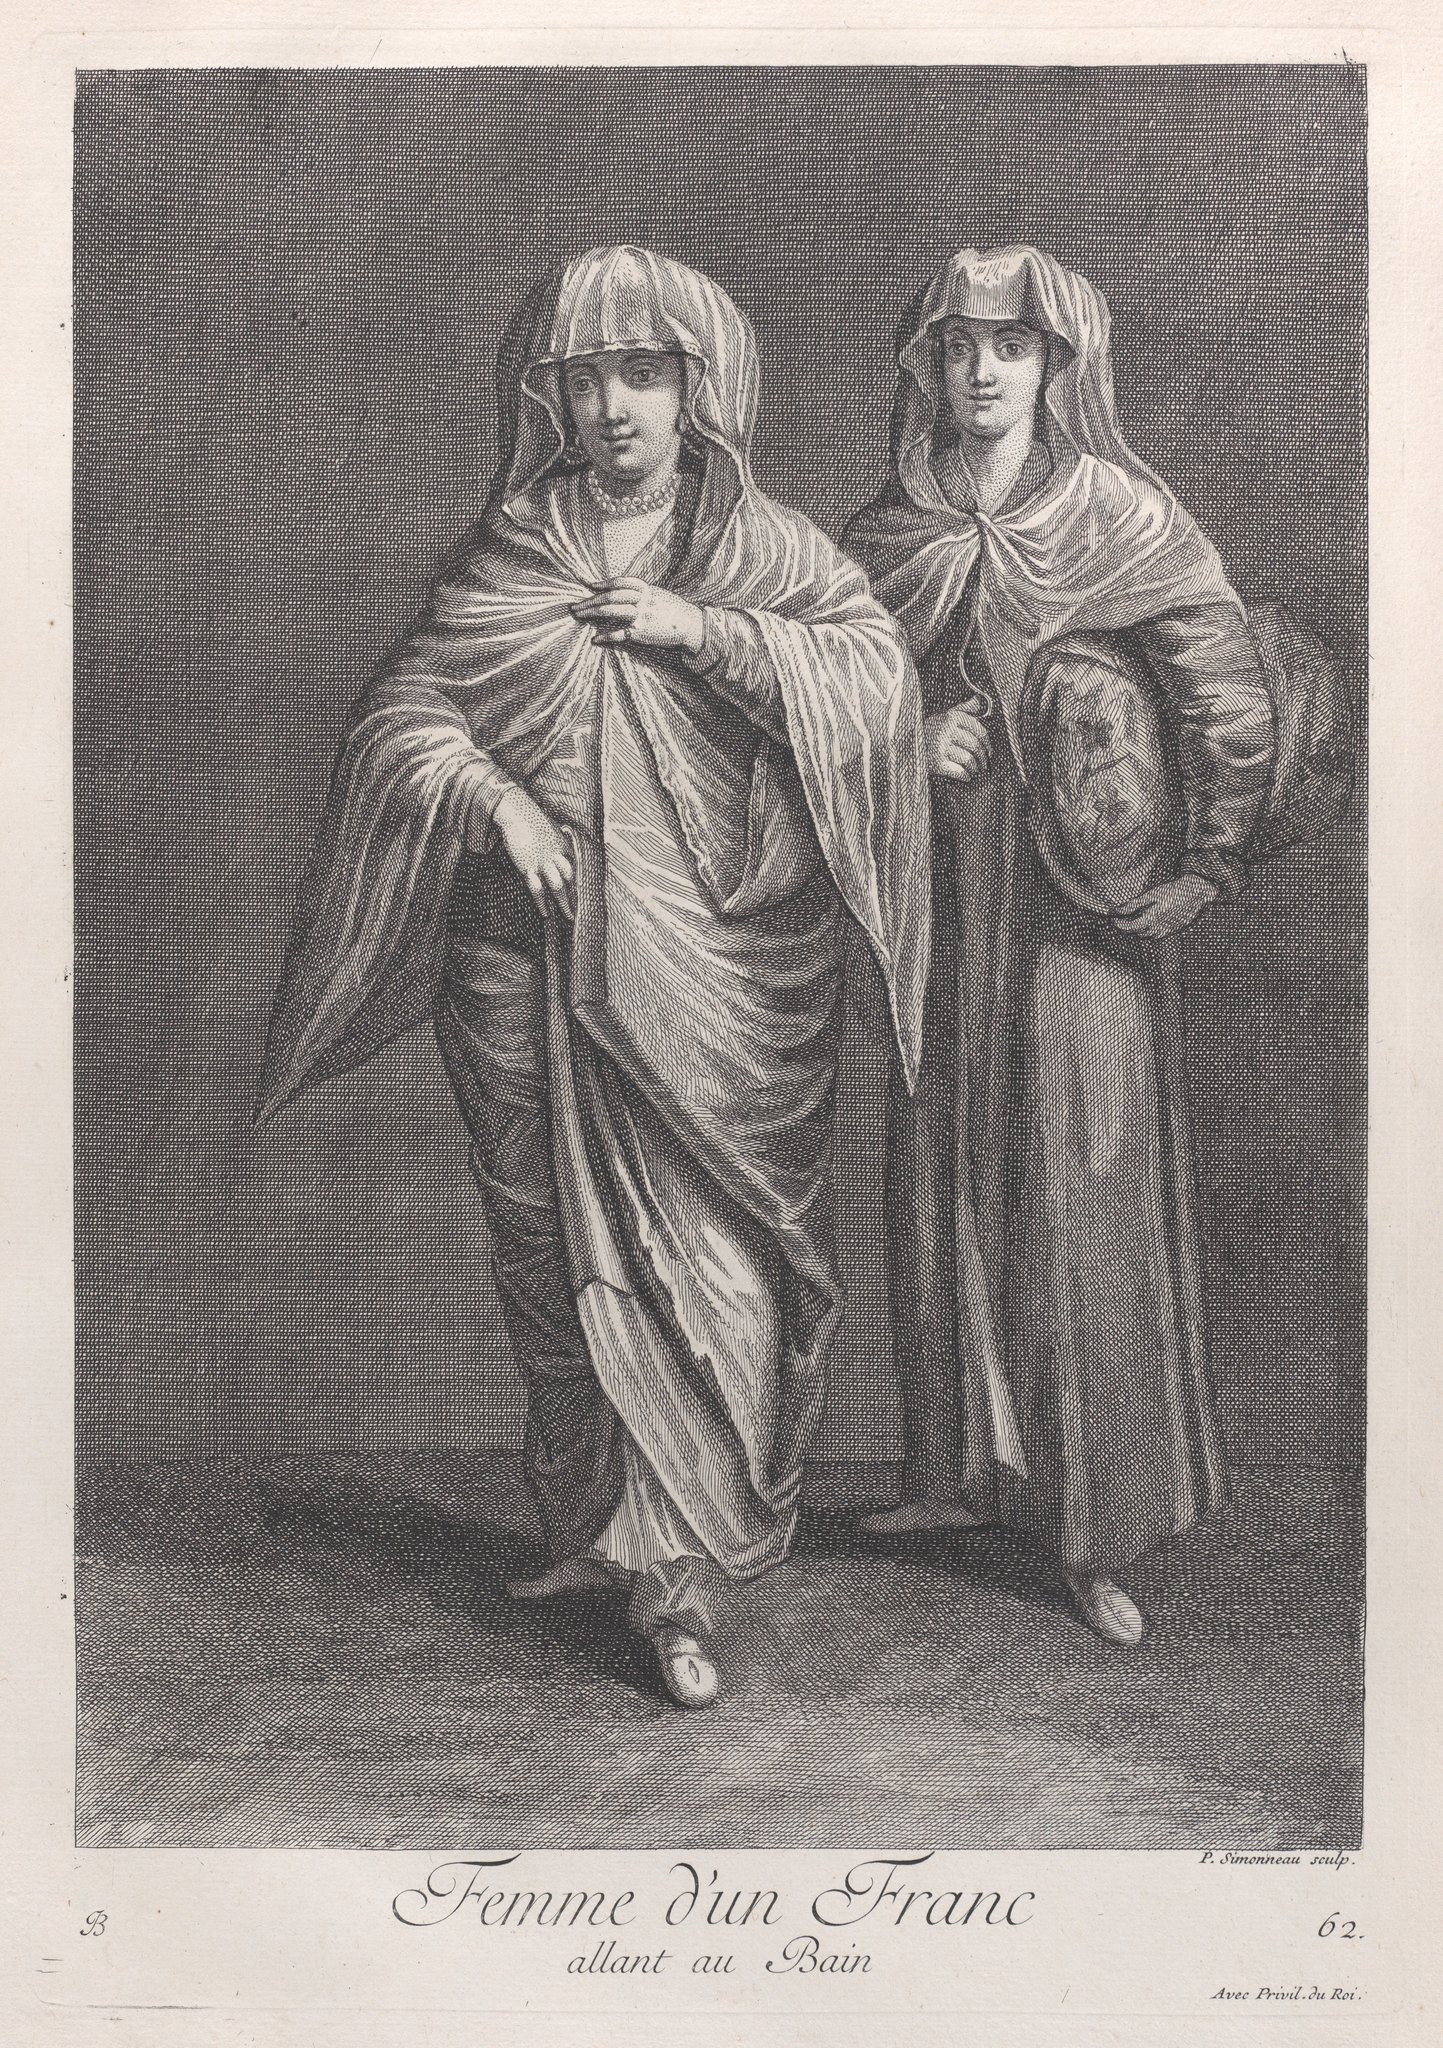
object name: print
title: Femme d'un Franc, allant au Bain, plate 62 from "Recueil de cent estampes représentent differentes nations du Levant"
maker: jean baptiste vanmour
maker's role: artist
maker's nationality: french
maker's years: 1671-1737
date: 1714-1715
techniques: engraving, etching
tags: women